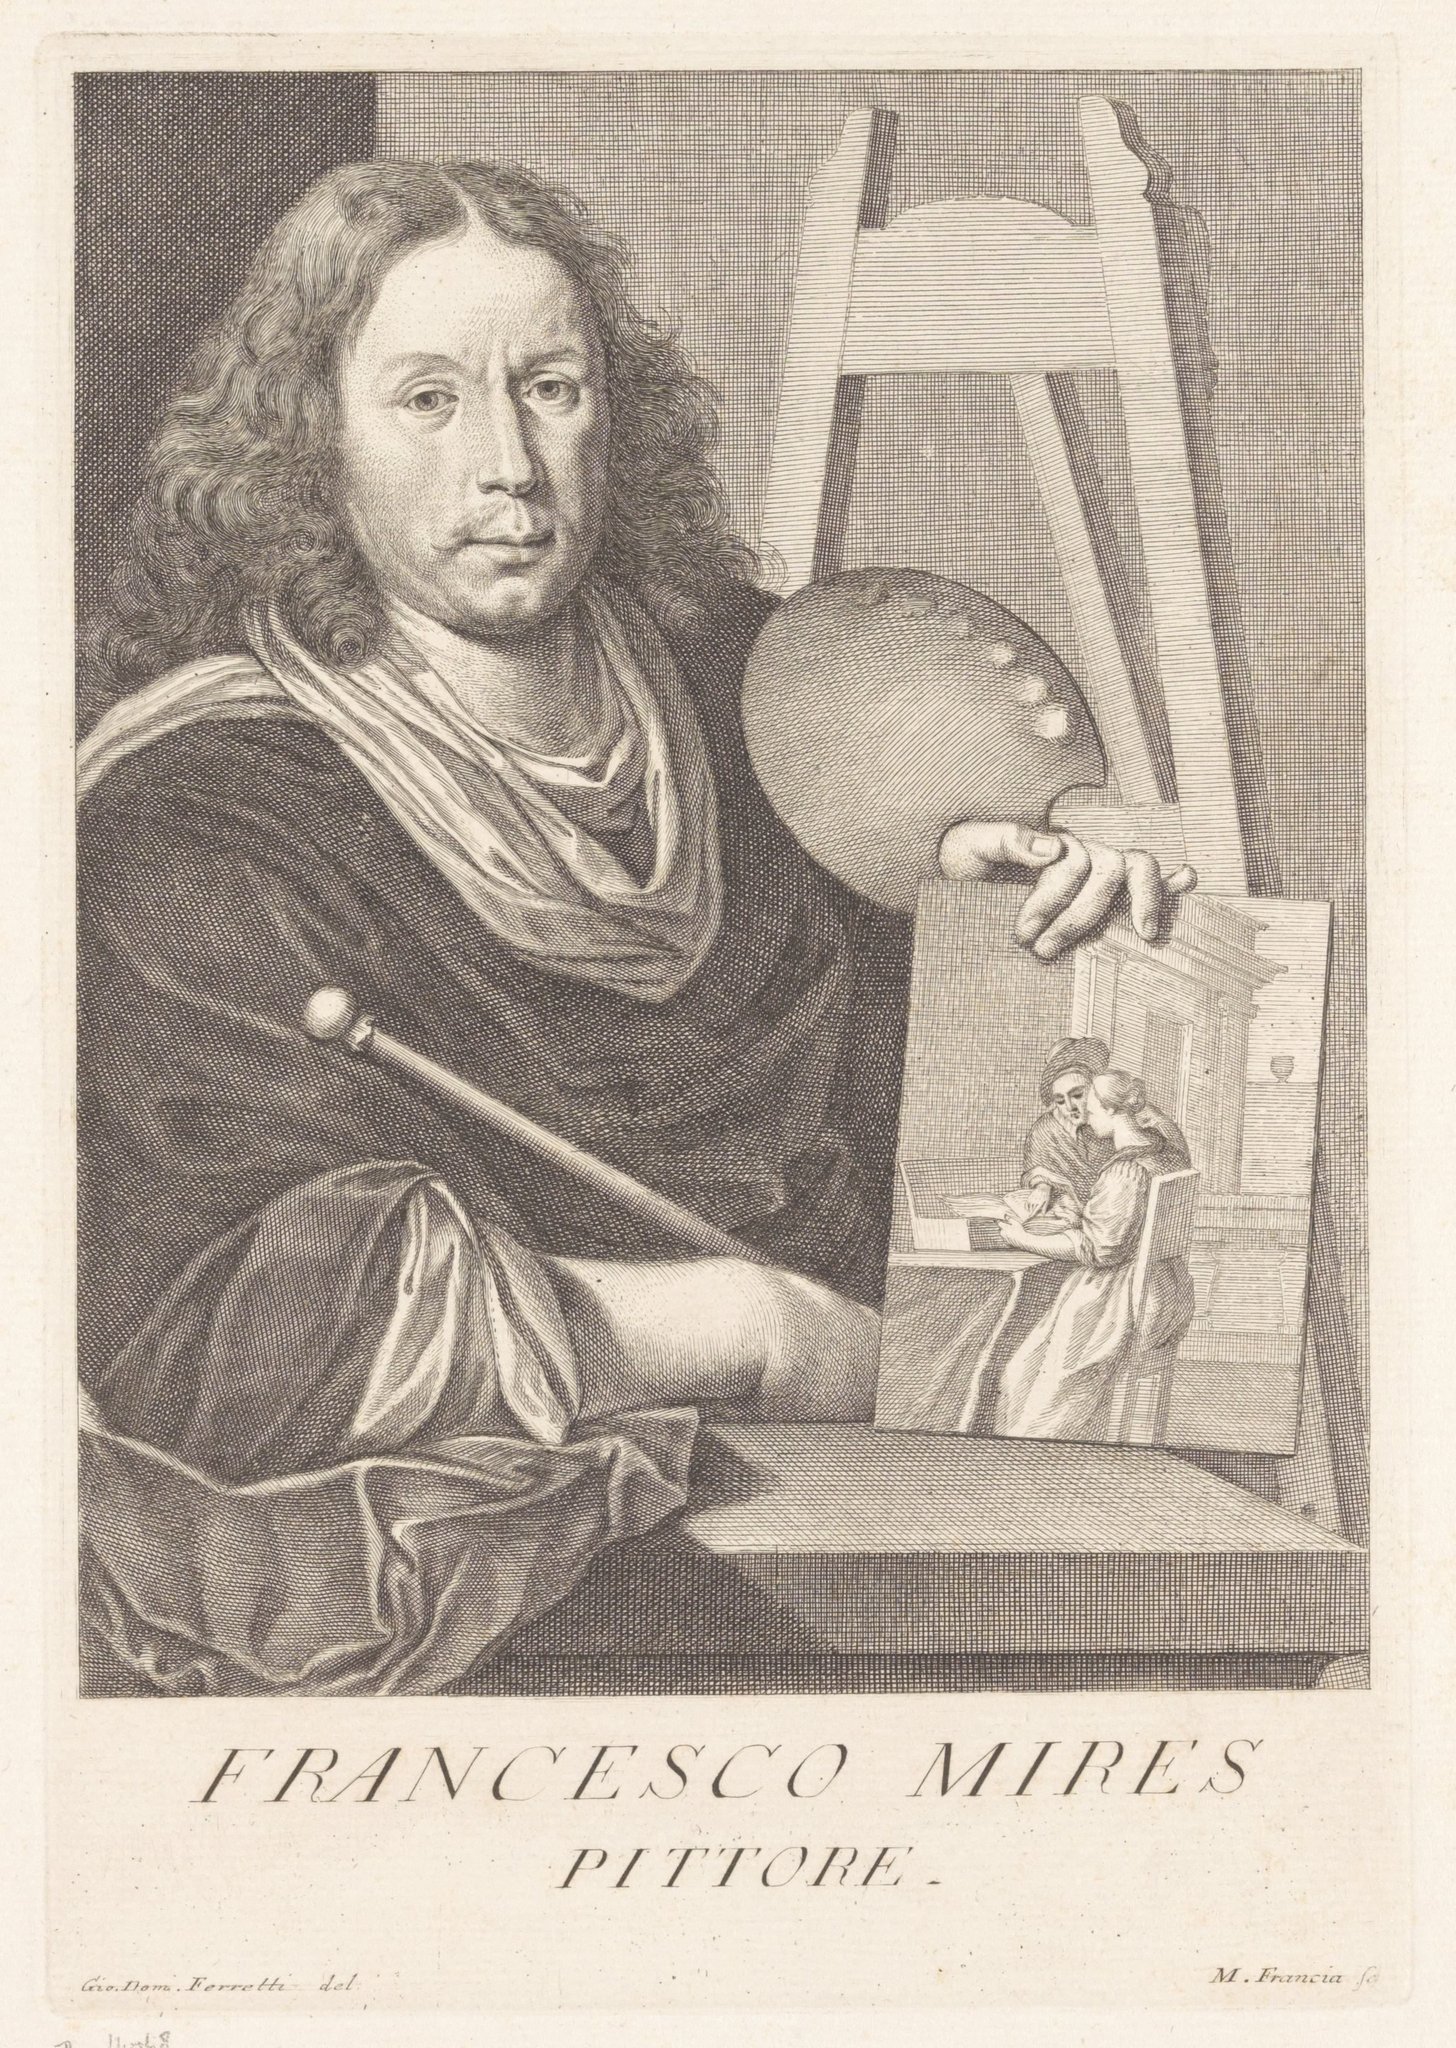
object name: book illustration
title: Portretten van kunstenaars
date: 1752-1762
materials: paper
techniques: engraving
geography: italy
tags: leiden, painter, print maker, draughtsman, frans van mieris (i), historical persons, portrait, self-portrait of artist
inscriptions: collector's mark, collector's mark: Lugt 2760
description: Prent uit: Moücke, Francesco. Serie di ritratti degli eccellenti pittori dipinti di propria mano, che esistono nell'Imiperial Galleria di Firenze. Florence: 1752-1762, dl. III.